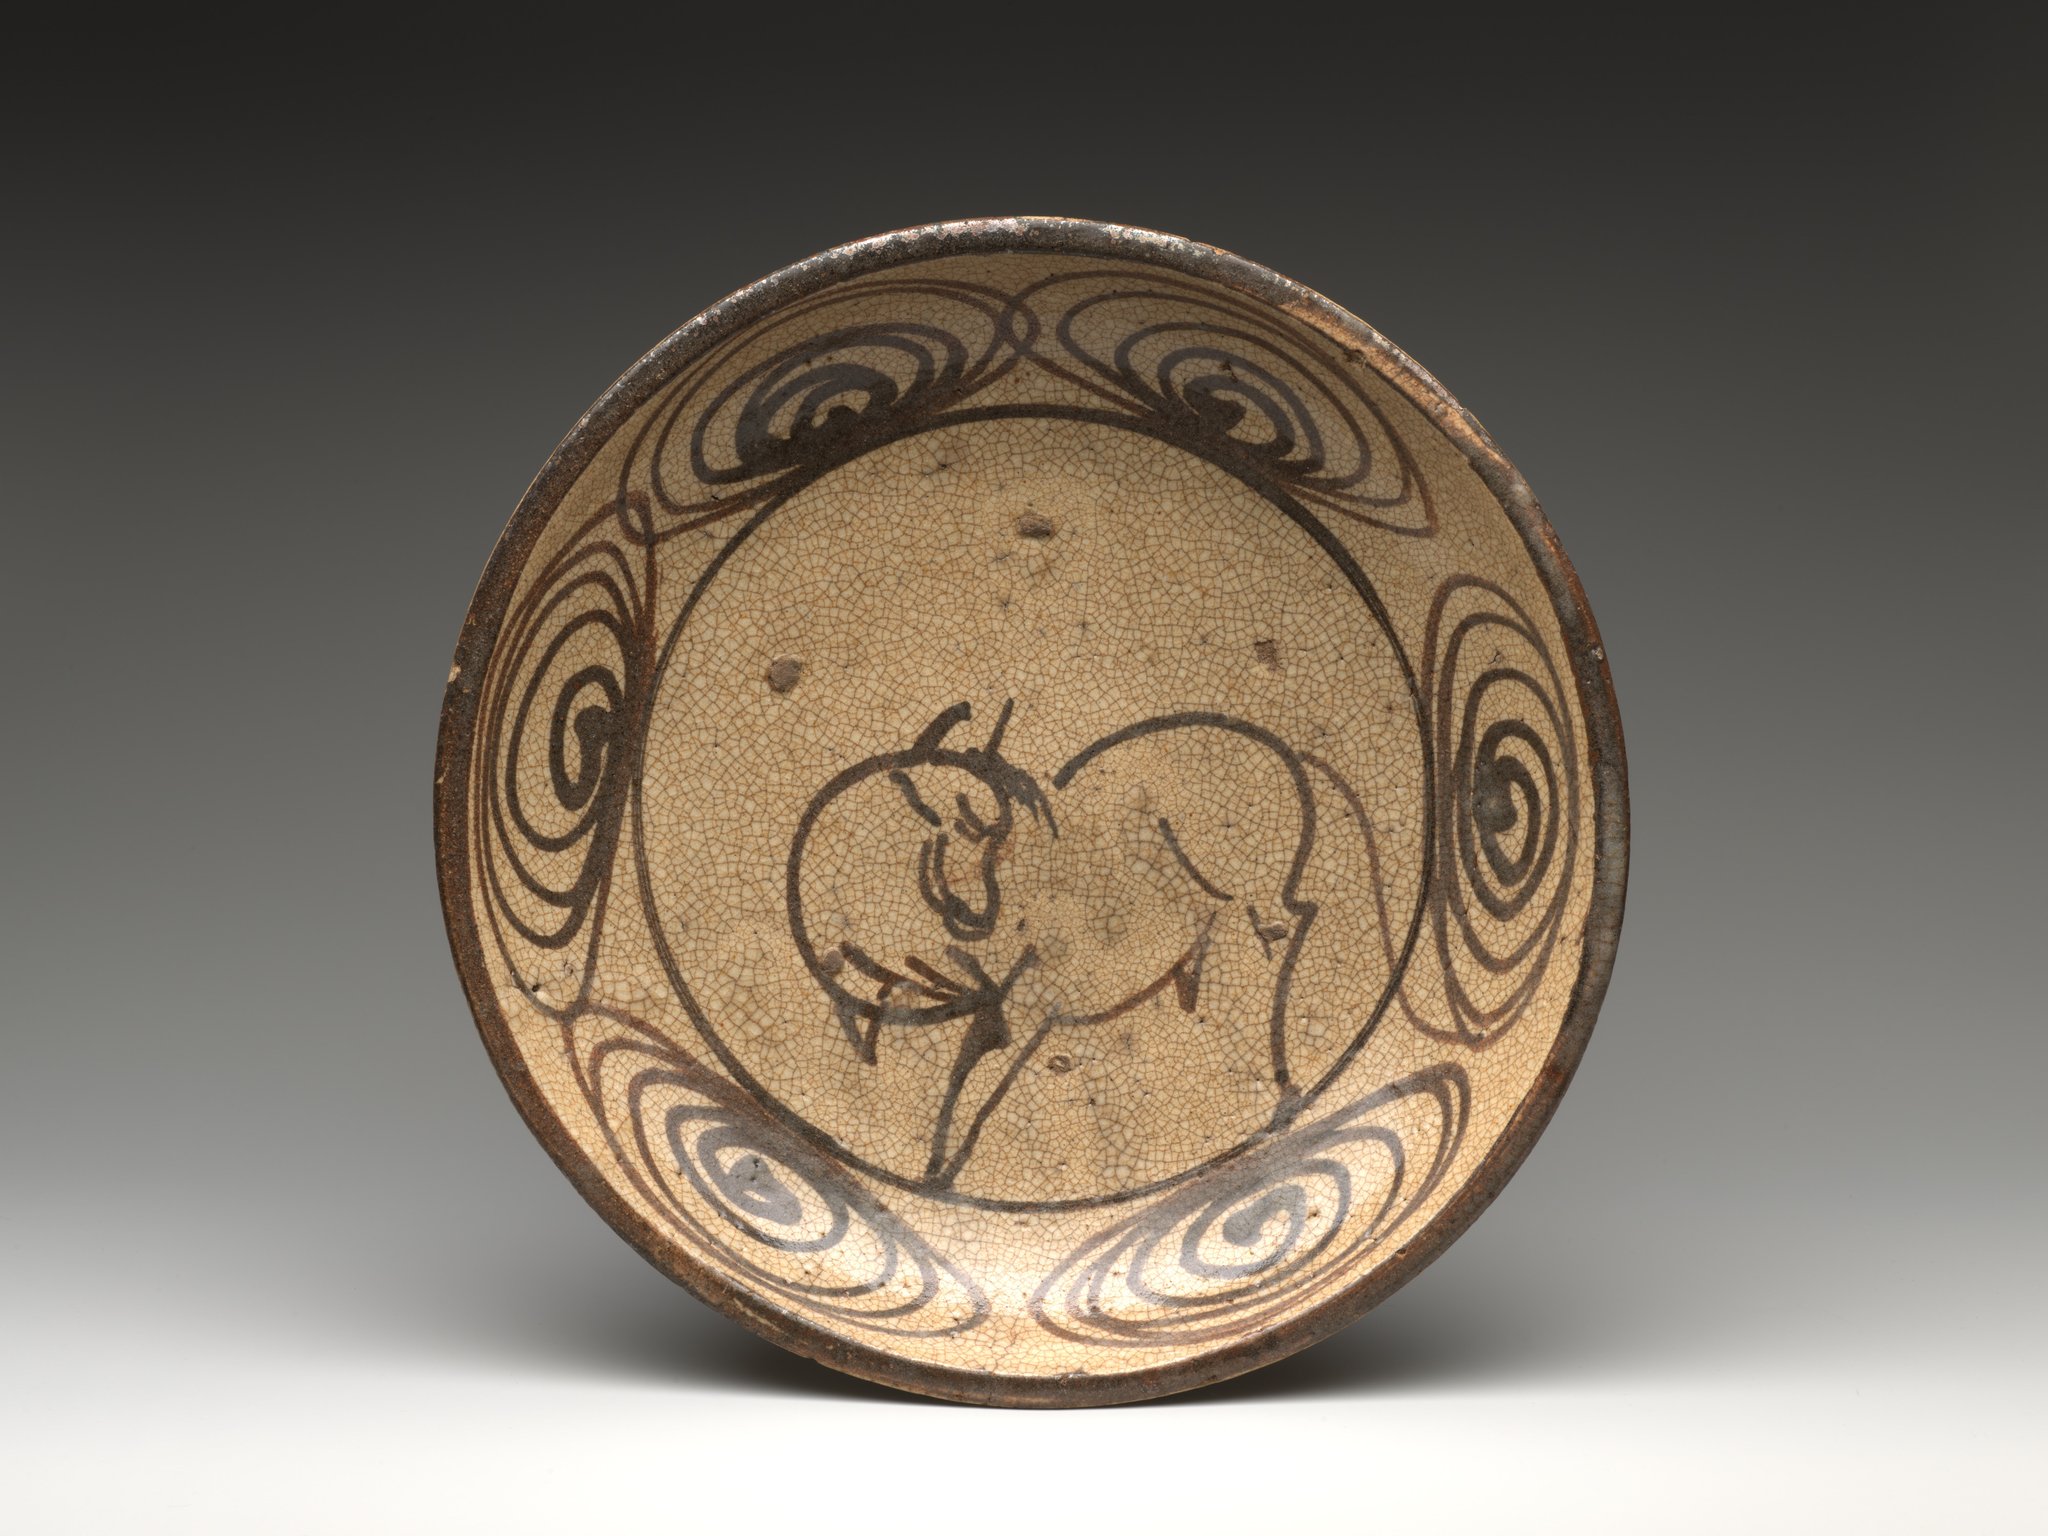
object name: plate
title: Ishizara Plate with Design of Horse and Spirals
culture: japanese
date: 1801-1833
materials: stoneware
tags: horses